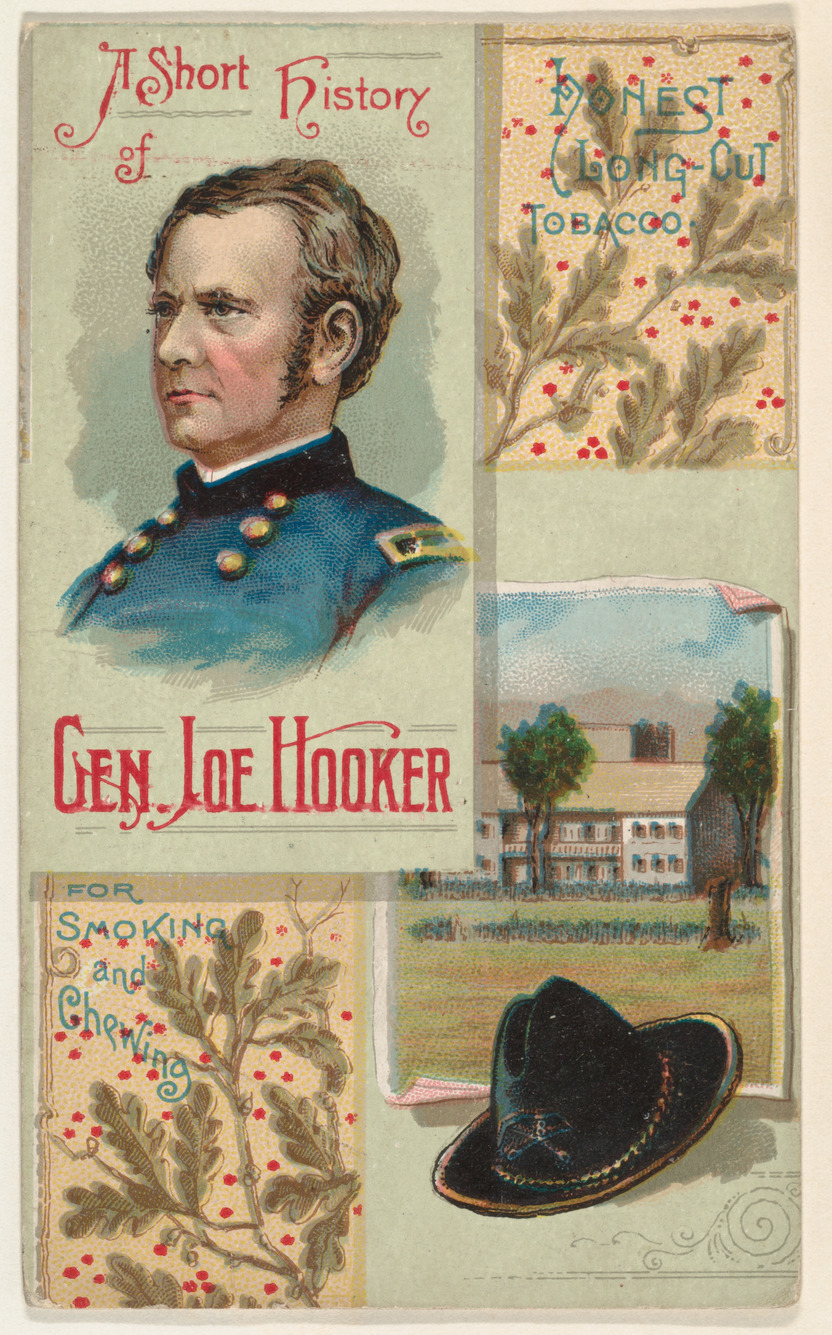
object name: print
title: A Short History of General Joe Hooker, from the Histories of Generals series (N114) issued by W. Duke, Sons & Co. to promote Honest Long Cut Smoking and Chewing Tobacco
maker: w. duke, sons & co.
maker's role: publisher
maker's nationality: american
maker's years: 1870-1920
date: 1888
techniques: color lithograph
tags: hats,men,profiles,generals